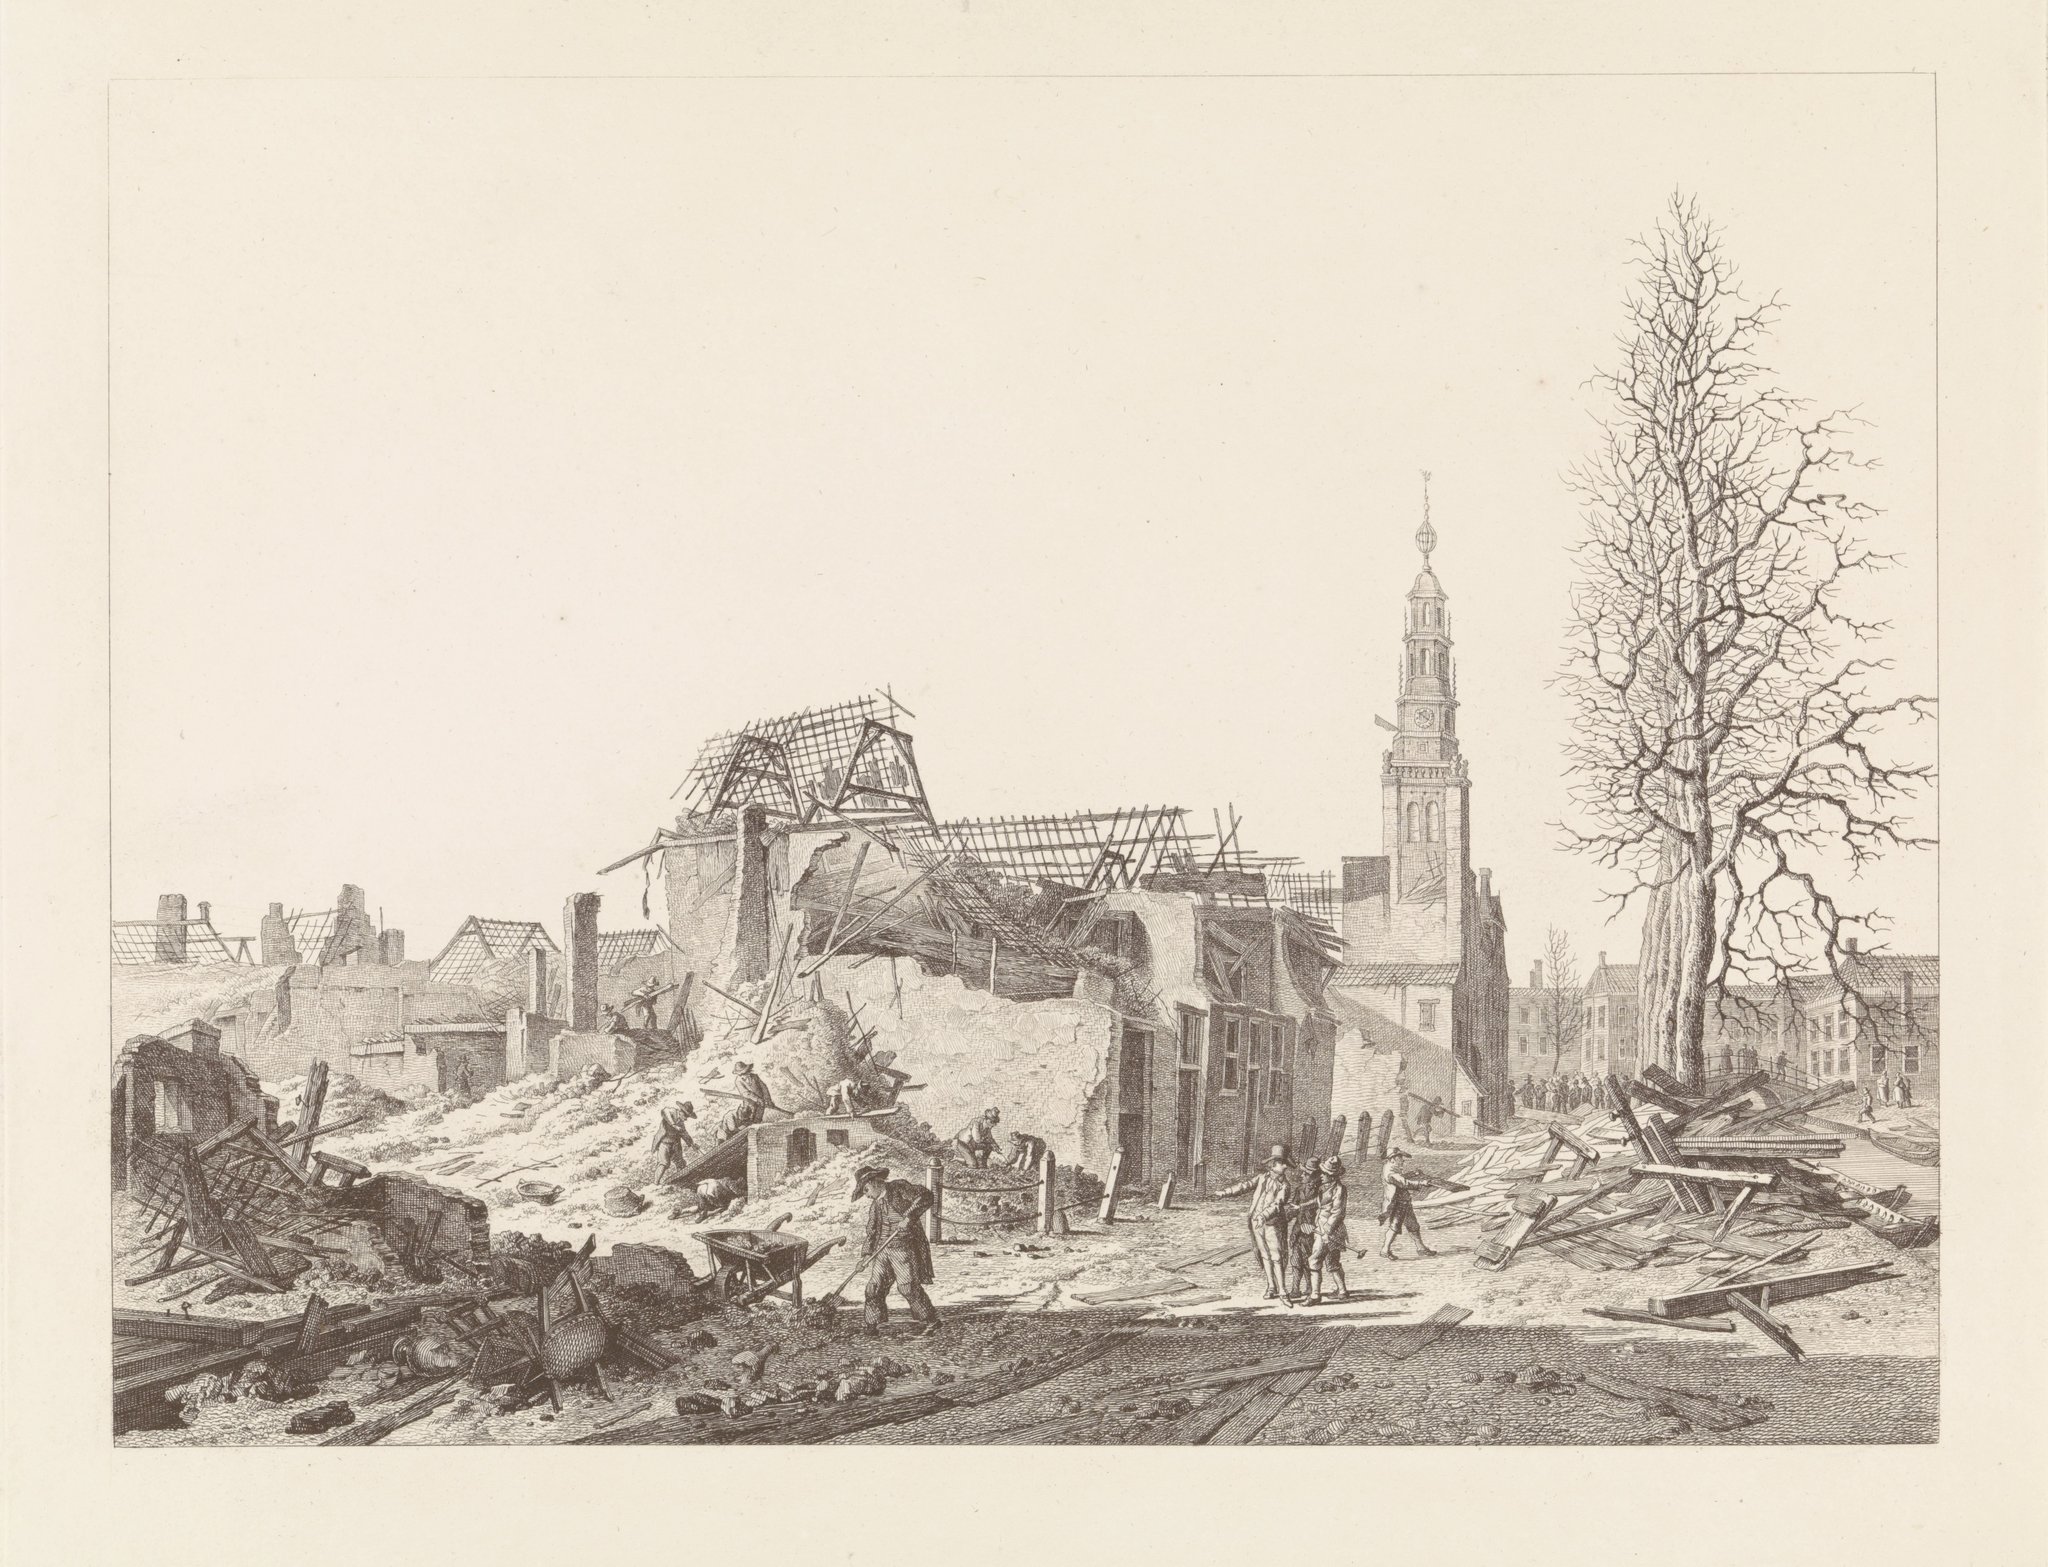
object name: history print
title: Gezicht op het Rapenburg te Leiden met de toren van de Saaihal na de buskruitramp van 12 januari 1807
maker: leendert overbeek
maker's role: draughtsman, painter, print maker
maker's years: 1752-1815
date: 1807-1809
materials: paper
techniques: etching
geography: haarlem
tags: gunpowder disaster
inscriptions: collector's mark: Lugt 2228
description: Gezicht op het Steenschuur, een gracht in het verlengde van het Rapenburg, te Leiden na de fatale buskruitramp van 12 januari 1807. In het midden is de toren van de Saaihal te zien. Reddingswerkers ruimen de brokstukken van de ontplofte gebouwen op. Planken worden naast de bomen langs de gracht verzameld.